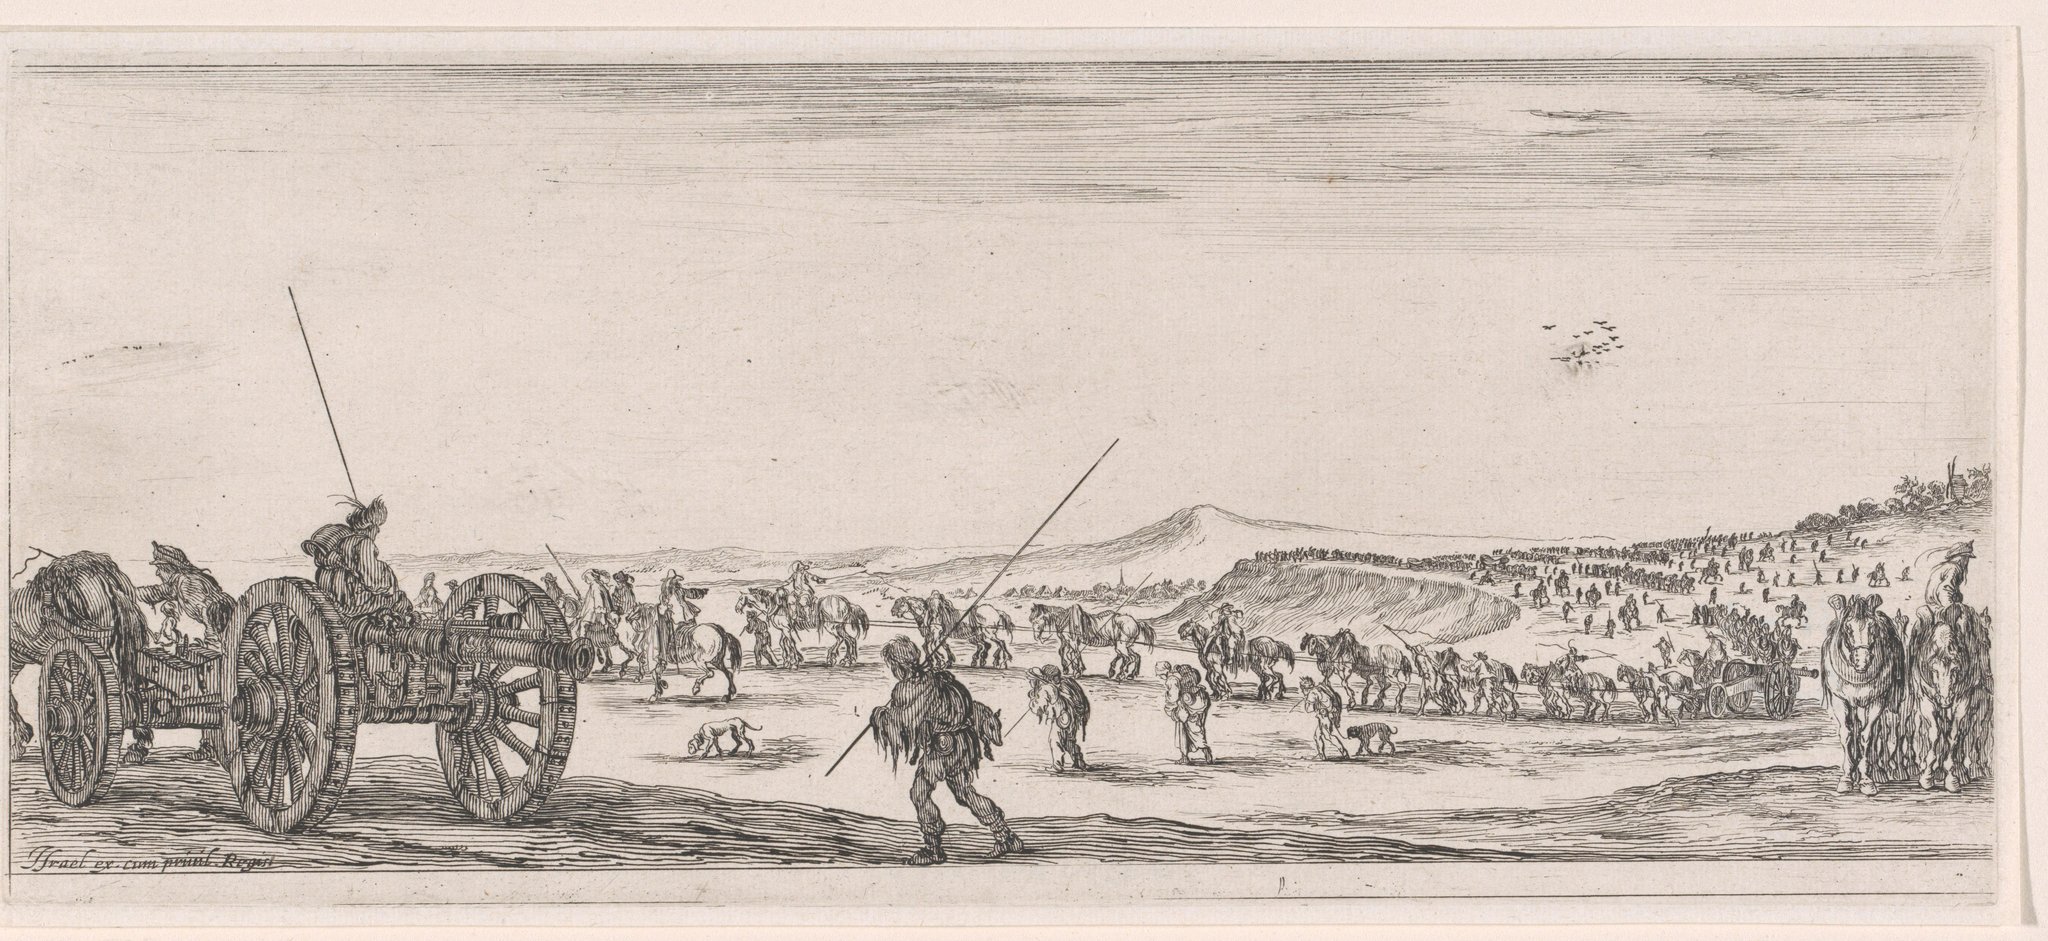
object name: print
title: Verschillende ontwerpen voor de vrede en voor de oorlog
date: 1620-1664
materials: paper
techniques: etching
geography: paris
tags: riding a horse, ass, or mule; rider, horseman, firearms: cannon (+ handling of weapons), firearms: cannon, the soldier; the soldier's life, (military) equipment and supply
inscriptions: collector's mark: Lugt 240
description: Prent uit een reeks van 6 prenten. Getekende voorstudie wordt bewaard in de Hermitage te St. Petersburg (inv. nr. 45103).